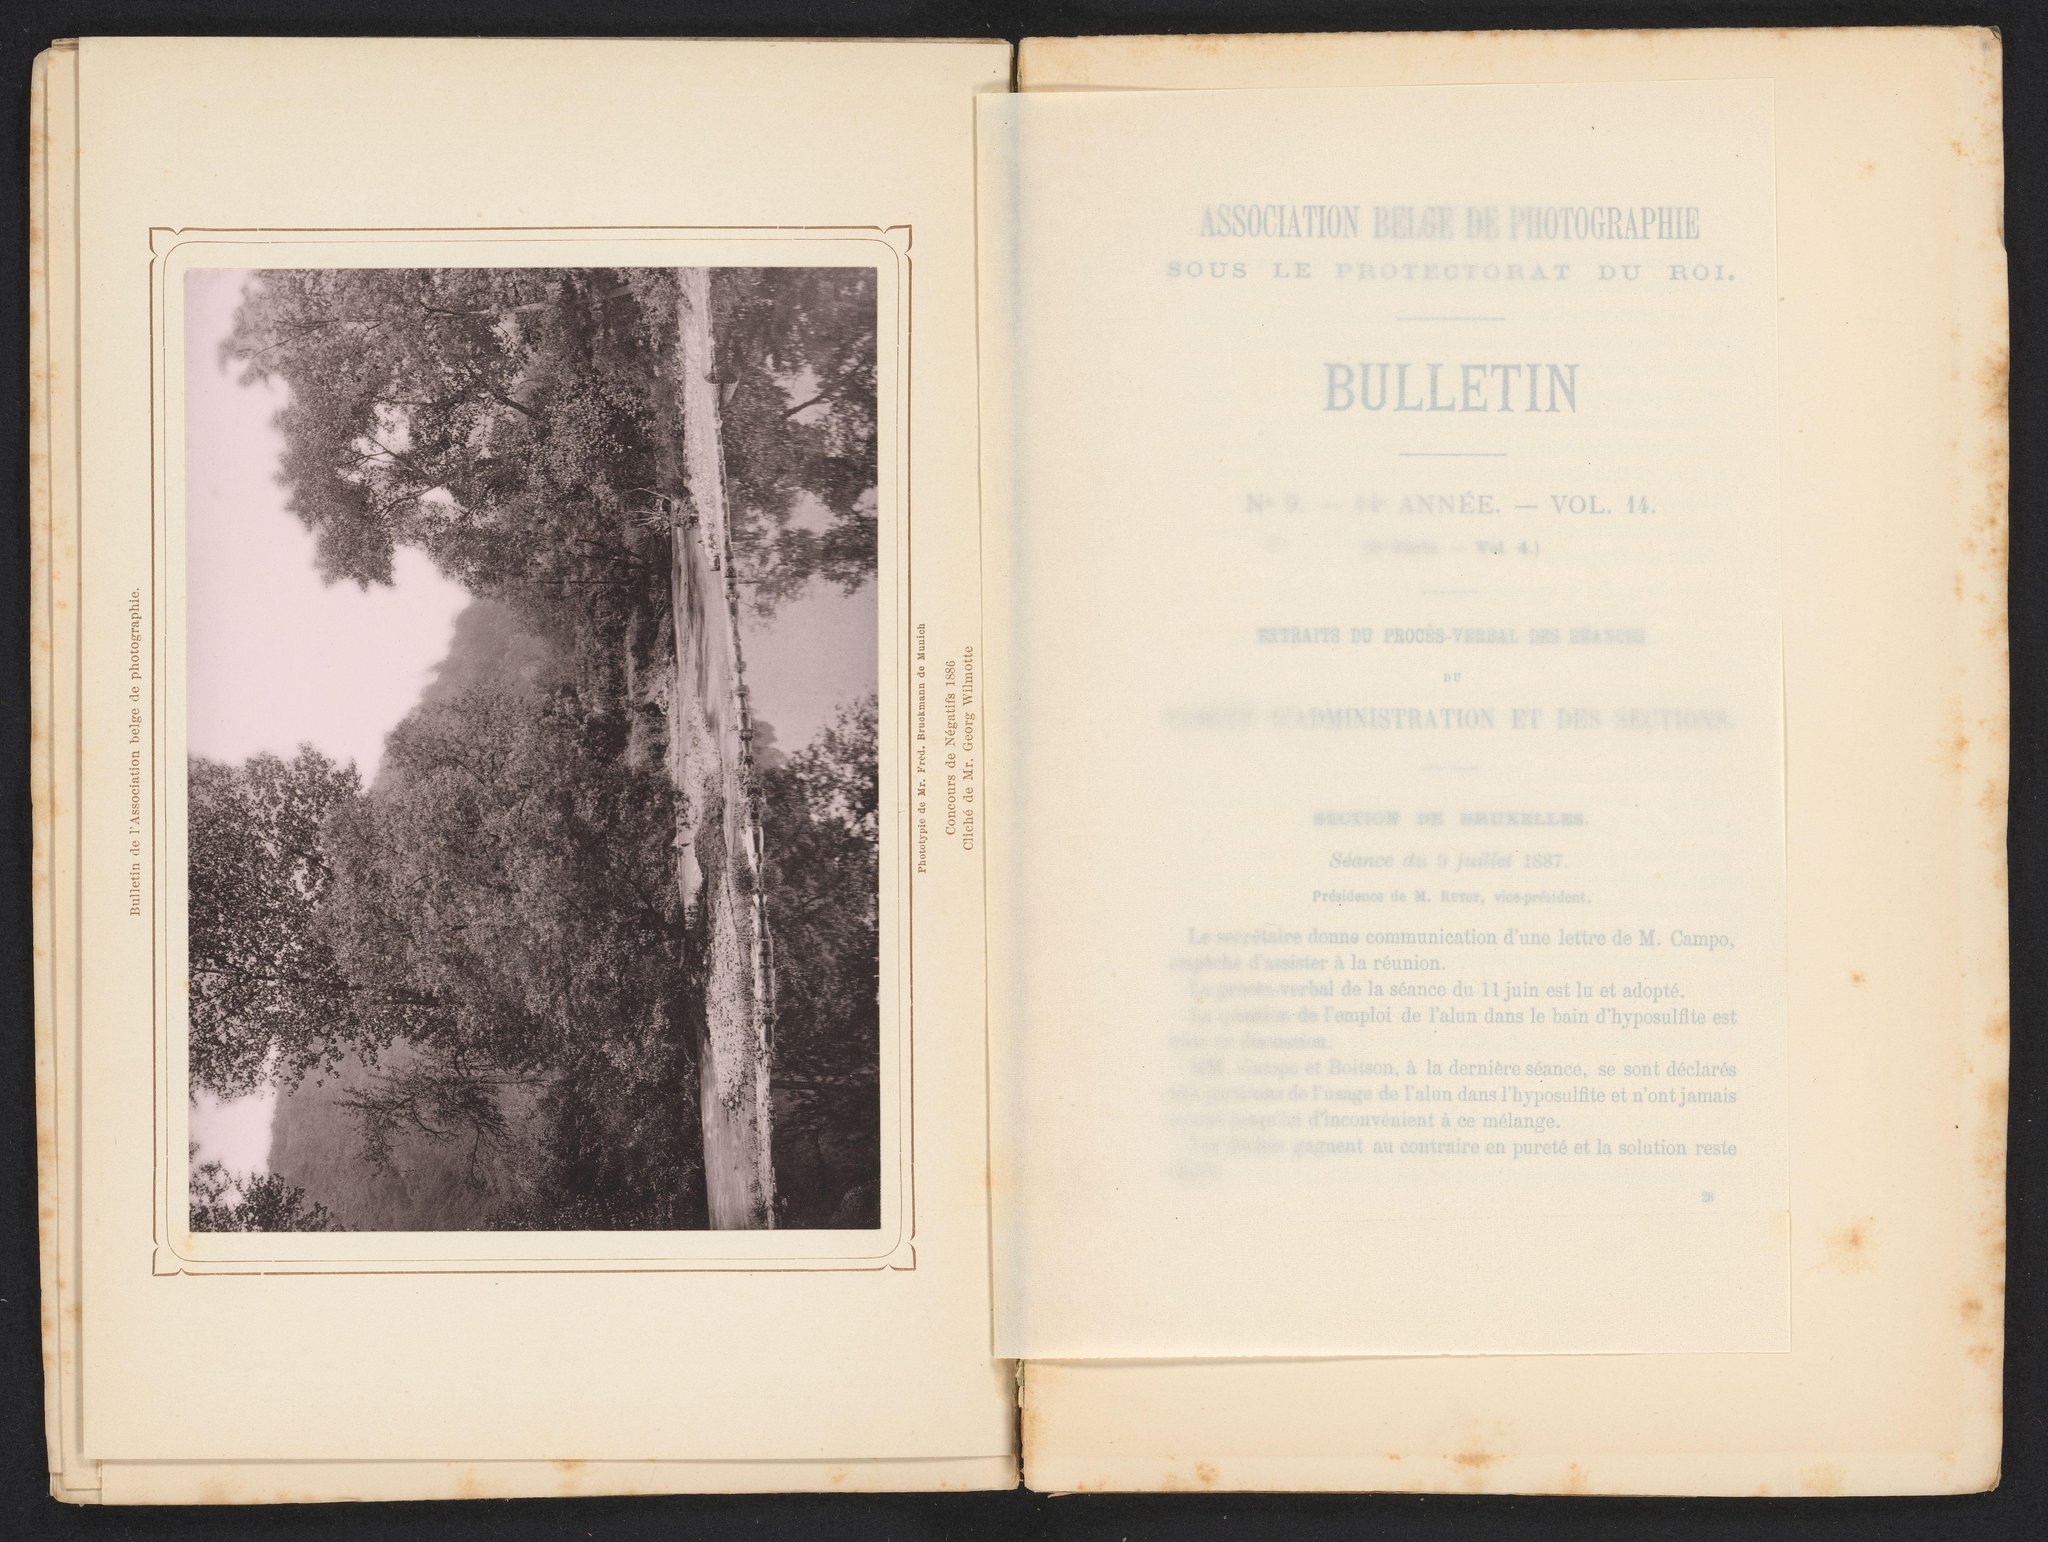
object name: photomechanical print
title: Landschap met waterpartij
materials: paper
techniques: photograph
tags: landscapes with waters, waterscapes, seascapes (in the temperate zone)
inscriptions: inscription: ‘Concours de Négatifs 1886/ Cliché de Mr. Georg Wilmotte’, inscription: ‘Bulletin de l'Association belge de photographie’